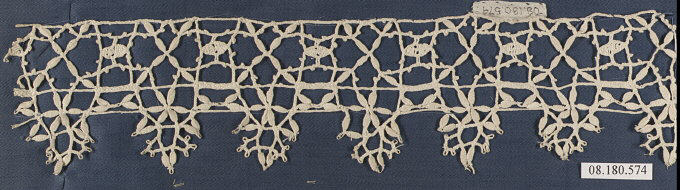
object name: fragment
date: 1601-1700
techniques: lace